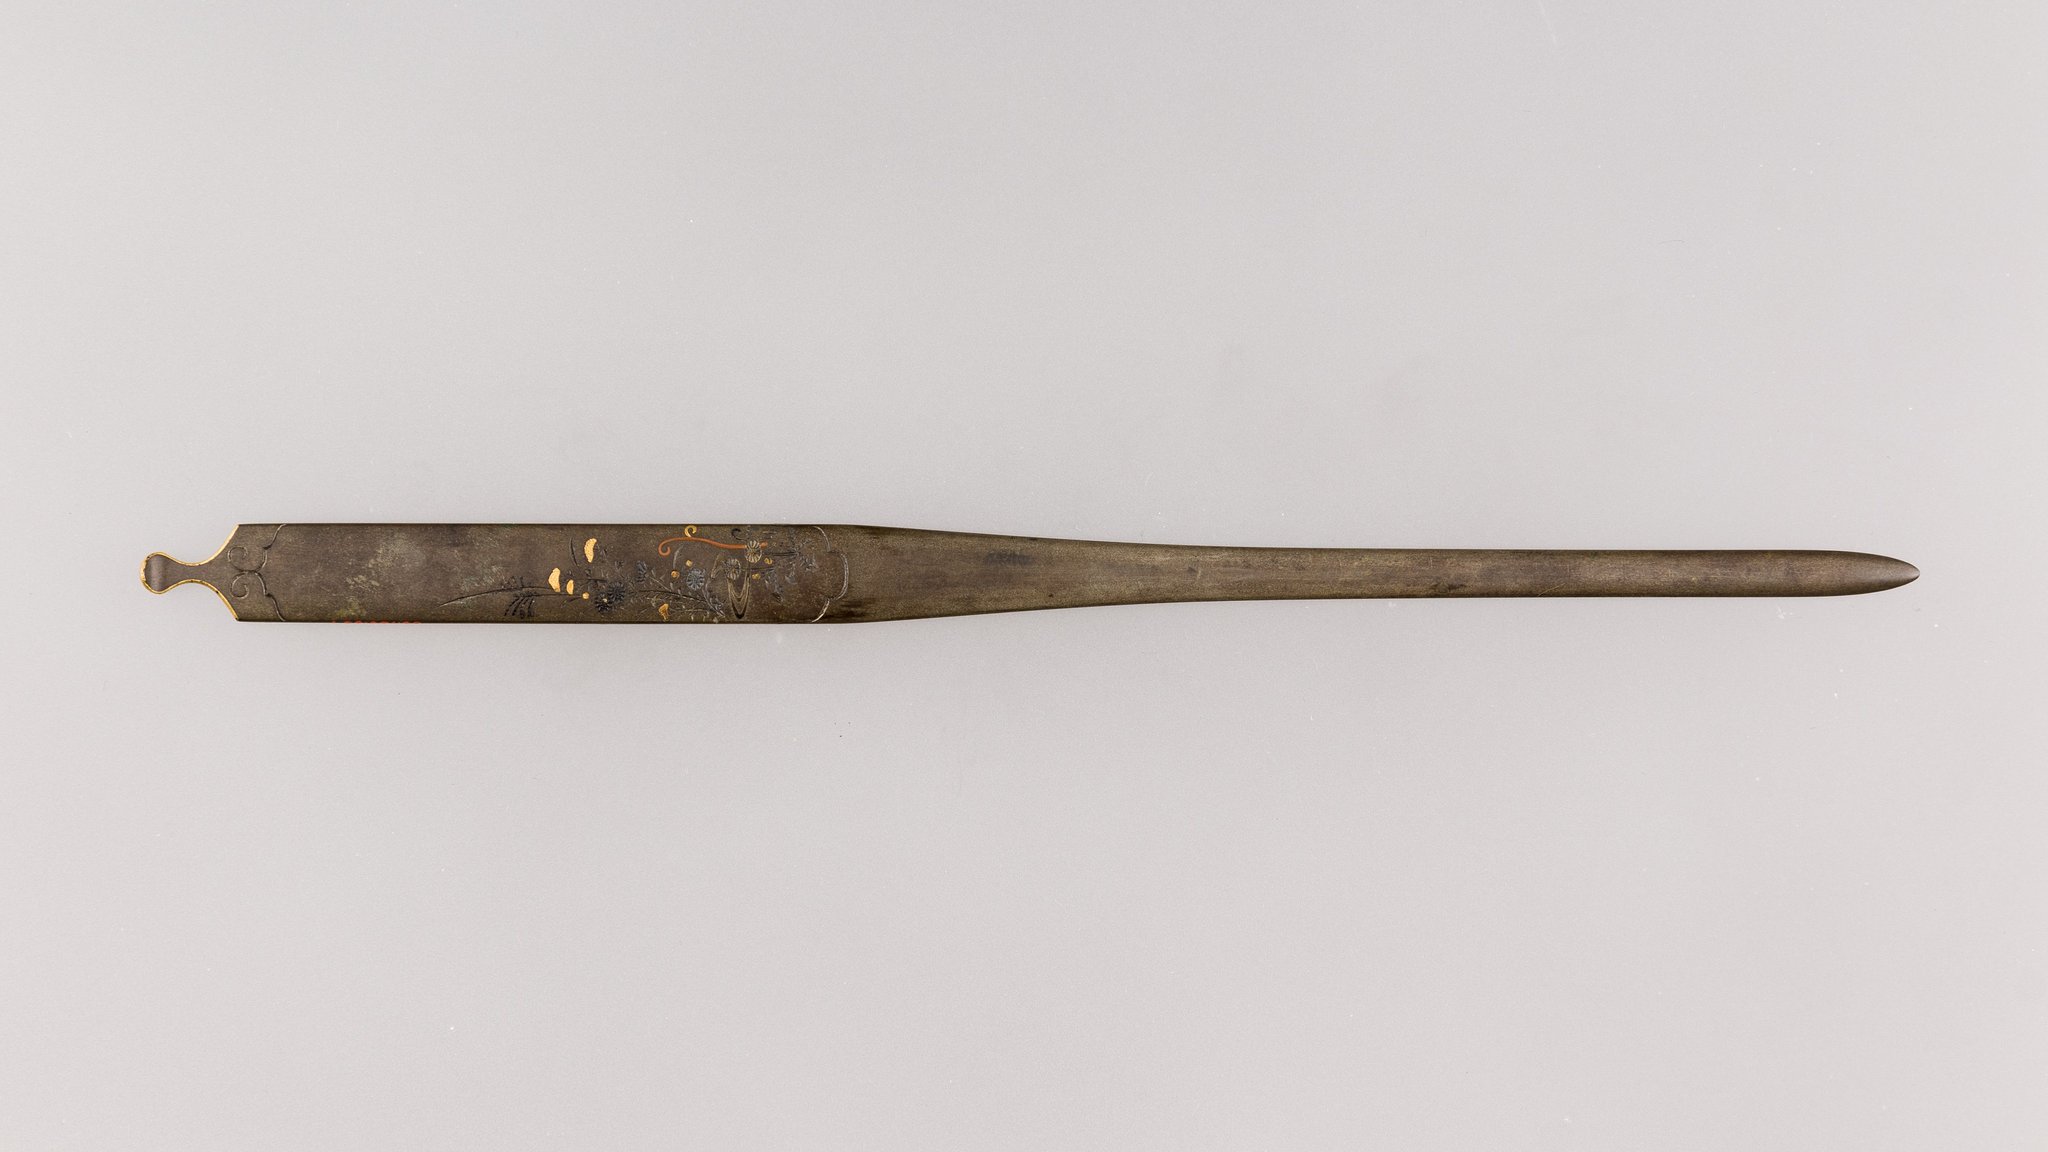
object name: hair dressing tool kogai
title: Hair Dressing Tool (Kogai)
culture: japanese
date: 1785-1876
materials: copper, gold alloy, silver alloy, gold, silver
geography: japan